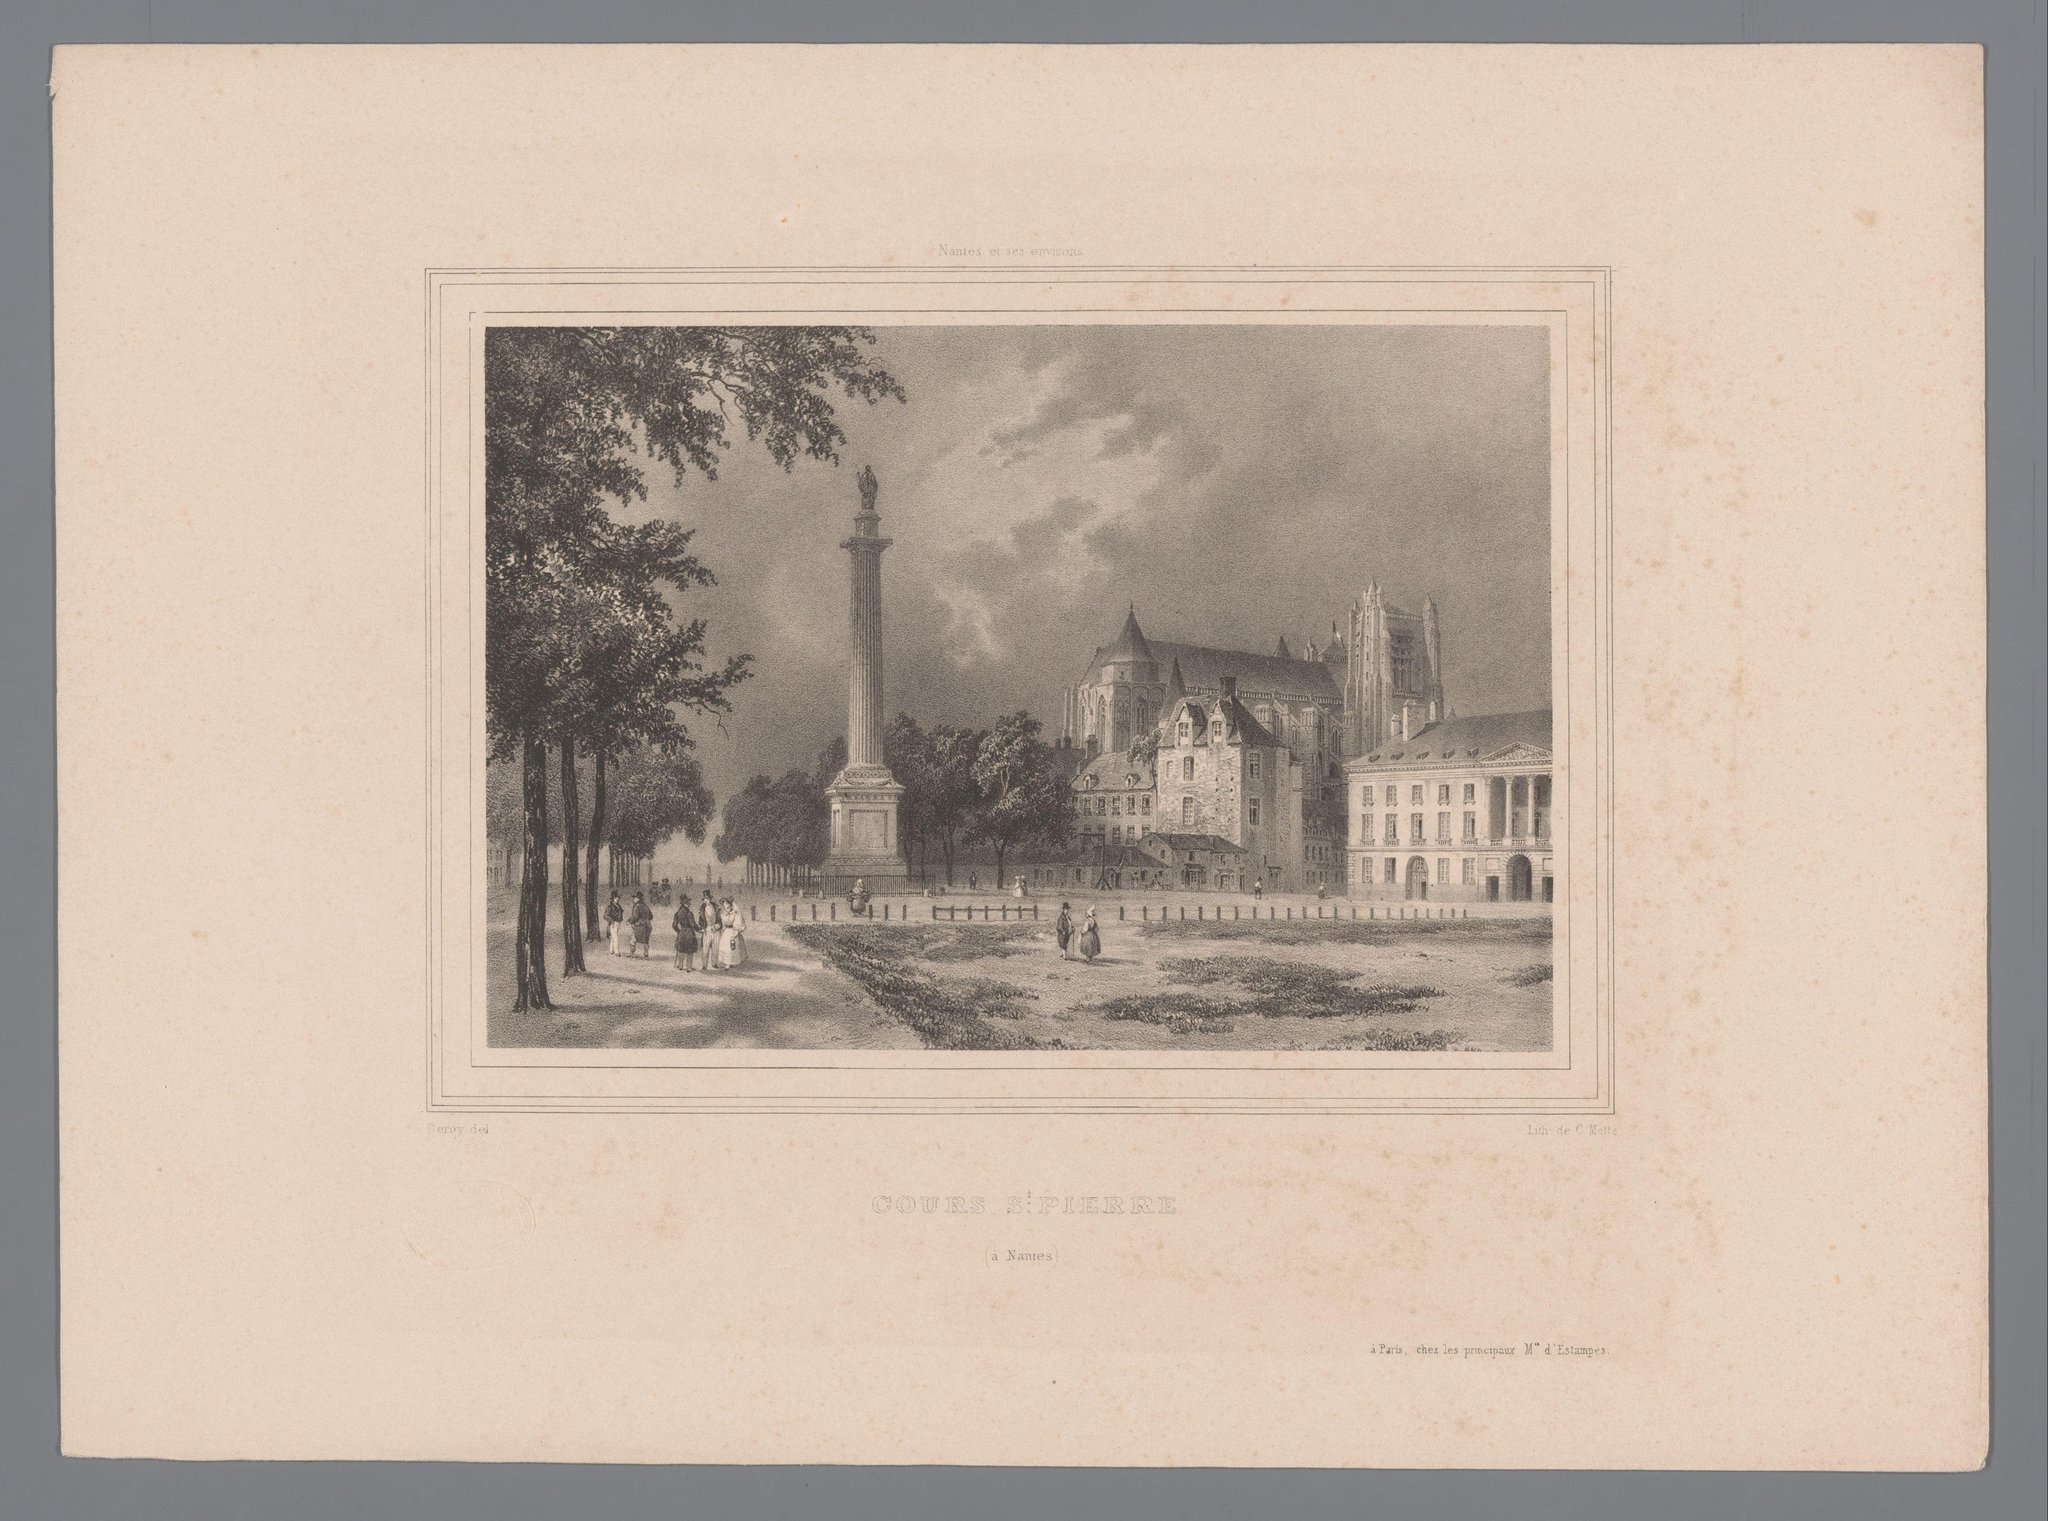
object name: print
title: Zicht op de Cours Saint-Pierre en Saint-André te Nantes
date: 1833-1835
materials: paper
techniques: lithograph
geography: nantes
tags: monument, statue (+ city(-scape) with figures, staffage), church (exterior), village square, place (+ city(-scape) with figures, staffage)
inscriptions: collector's mark: Lugt 2228a, check stamp: ‘Ch. Sebire. estampes et papiers peints. 8 Quai Brancas à Nantes.’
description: Prent maakt deel uit van een omslag met achttien prenten.